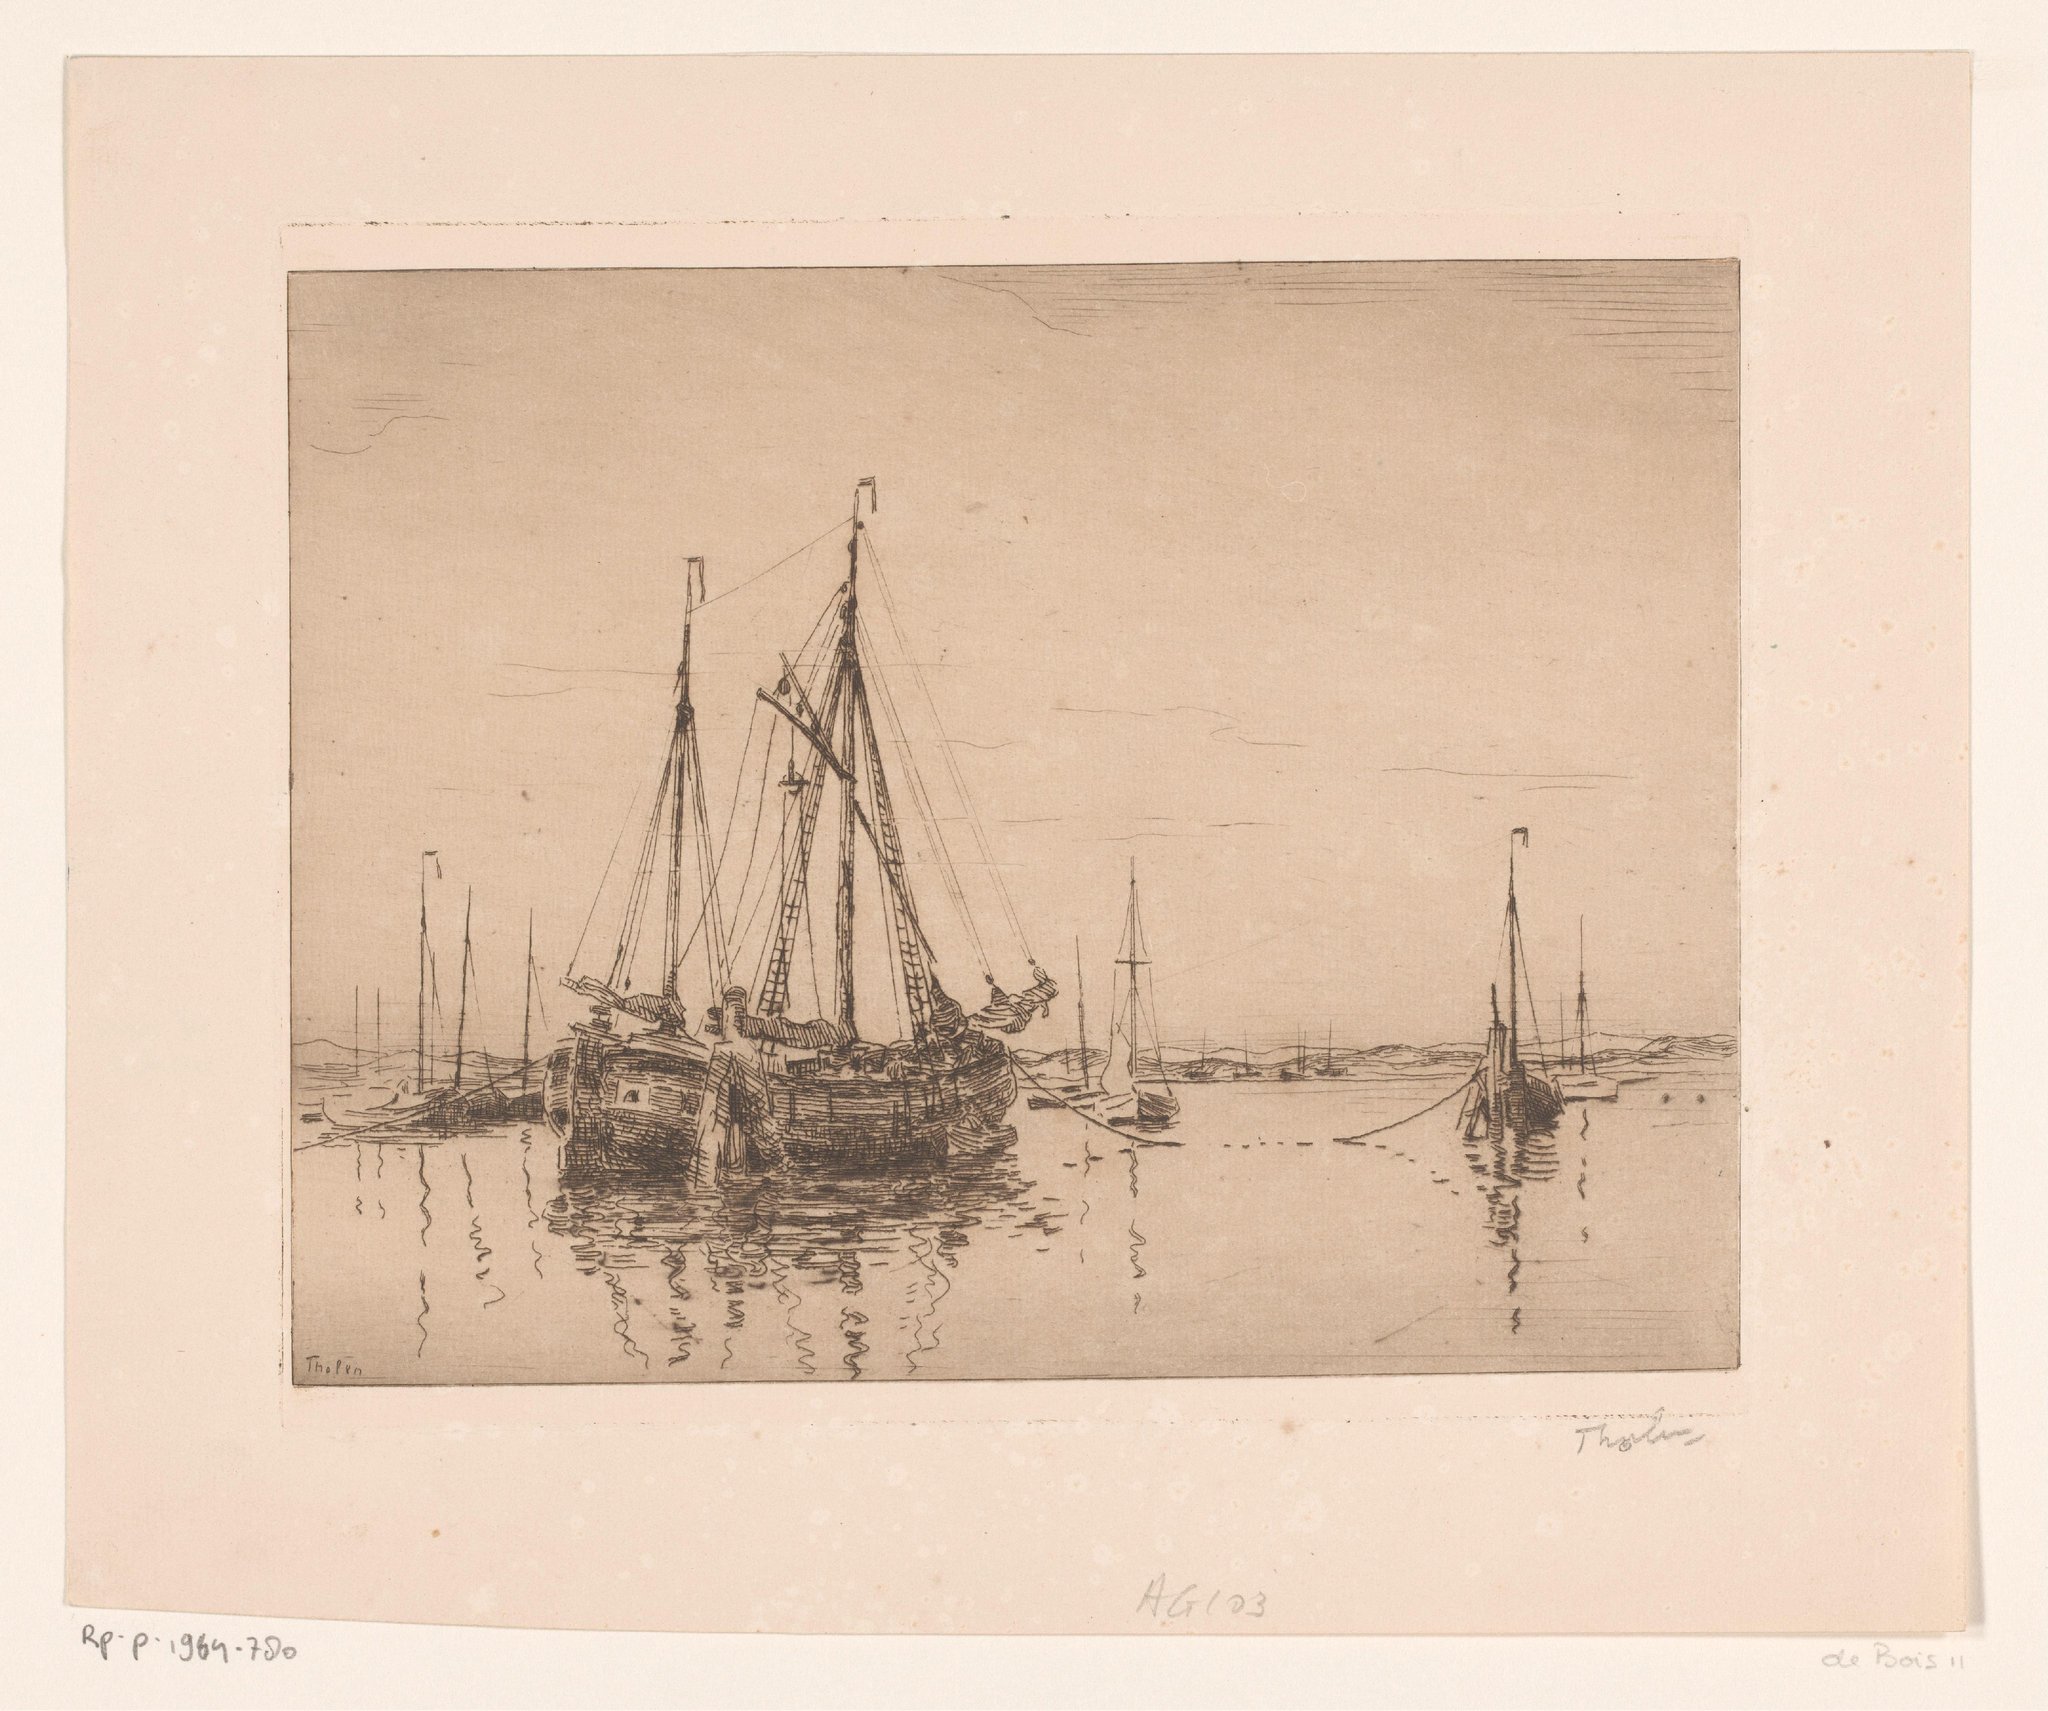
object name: print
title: Haven, Norderney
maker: willem bastiaan tholen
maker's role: draughtsman, painter, print maker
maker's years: 1860-1931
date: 1870-1914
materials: paper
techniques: etching, intaglio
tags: harbour, sailing-ship, sailing-boat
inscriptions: collector's mark: Lugt 2228